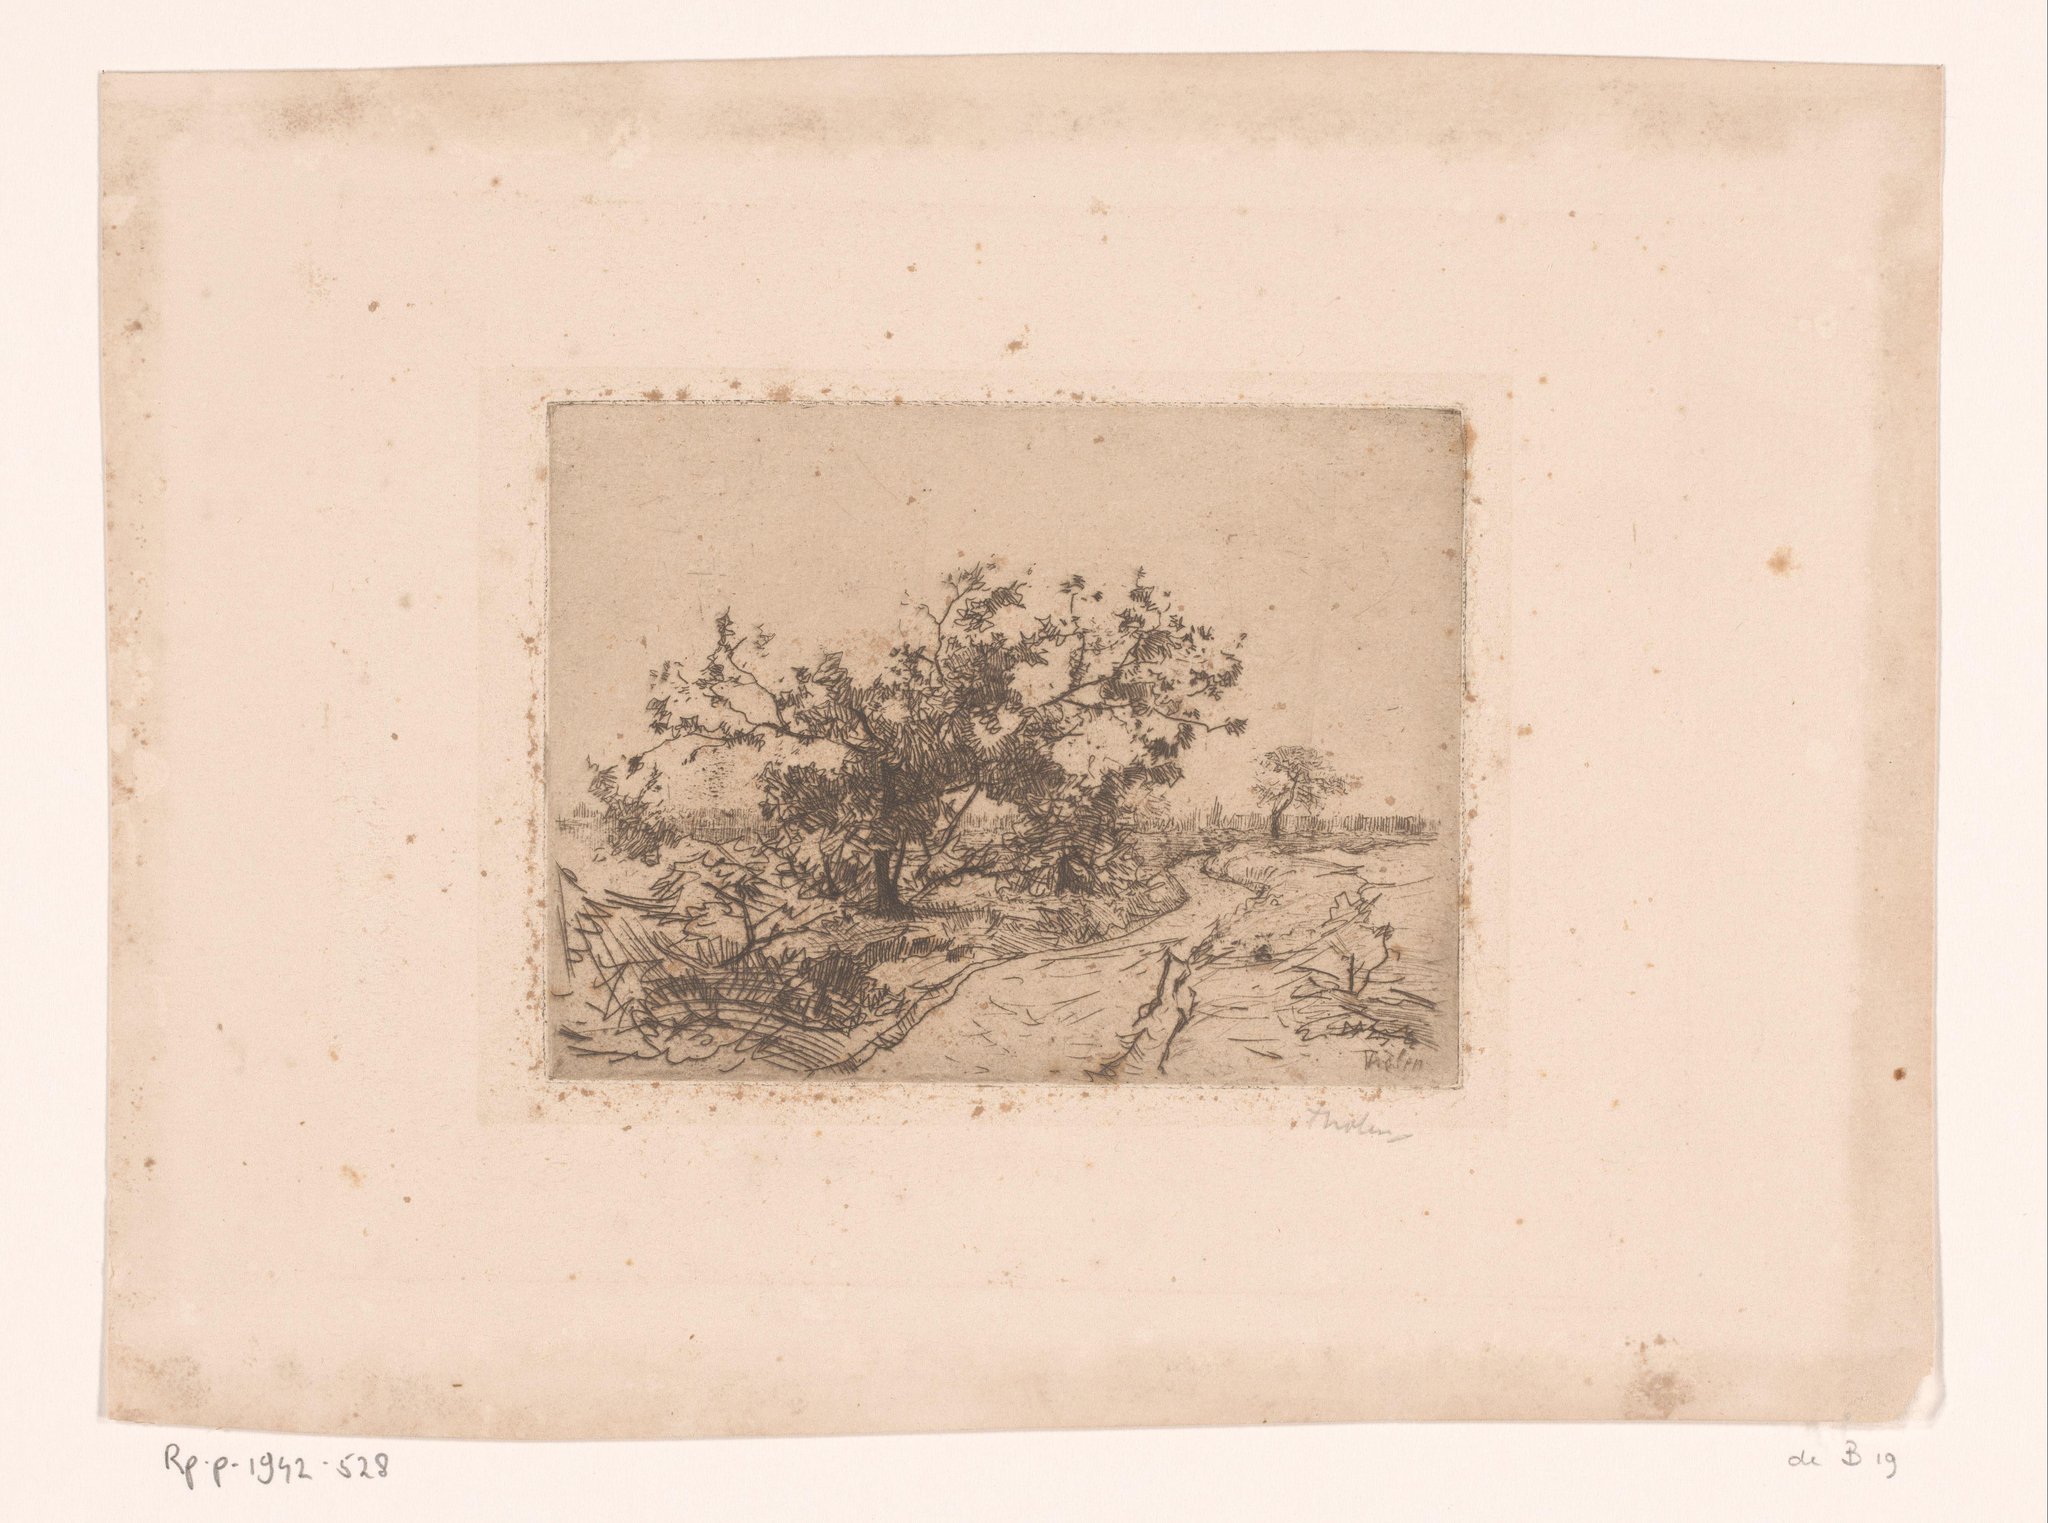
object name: print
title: Weg bij Ewijkshoeve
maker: willem bastiaan tholen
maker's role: draughtsman, painter, print maker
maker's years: 1860-1931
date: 1870-1914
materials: paper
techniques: etching, intaglio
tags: meadow, pasture, road, path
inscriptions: collector's mark: Lugt 2228